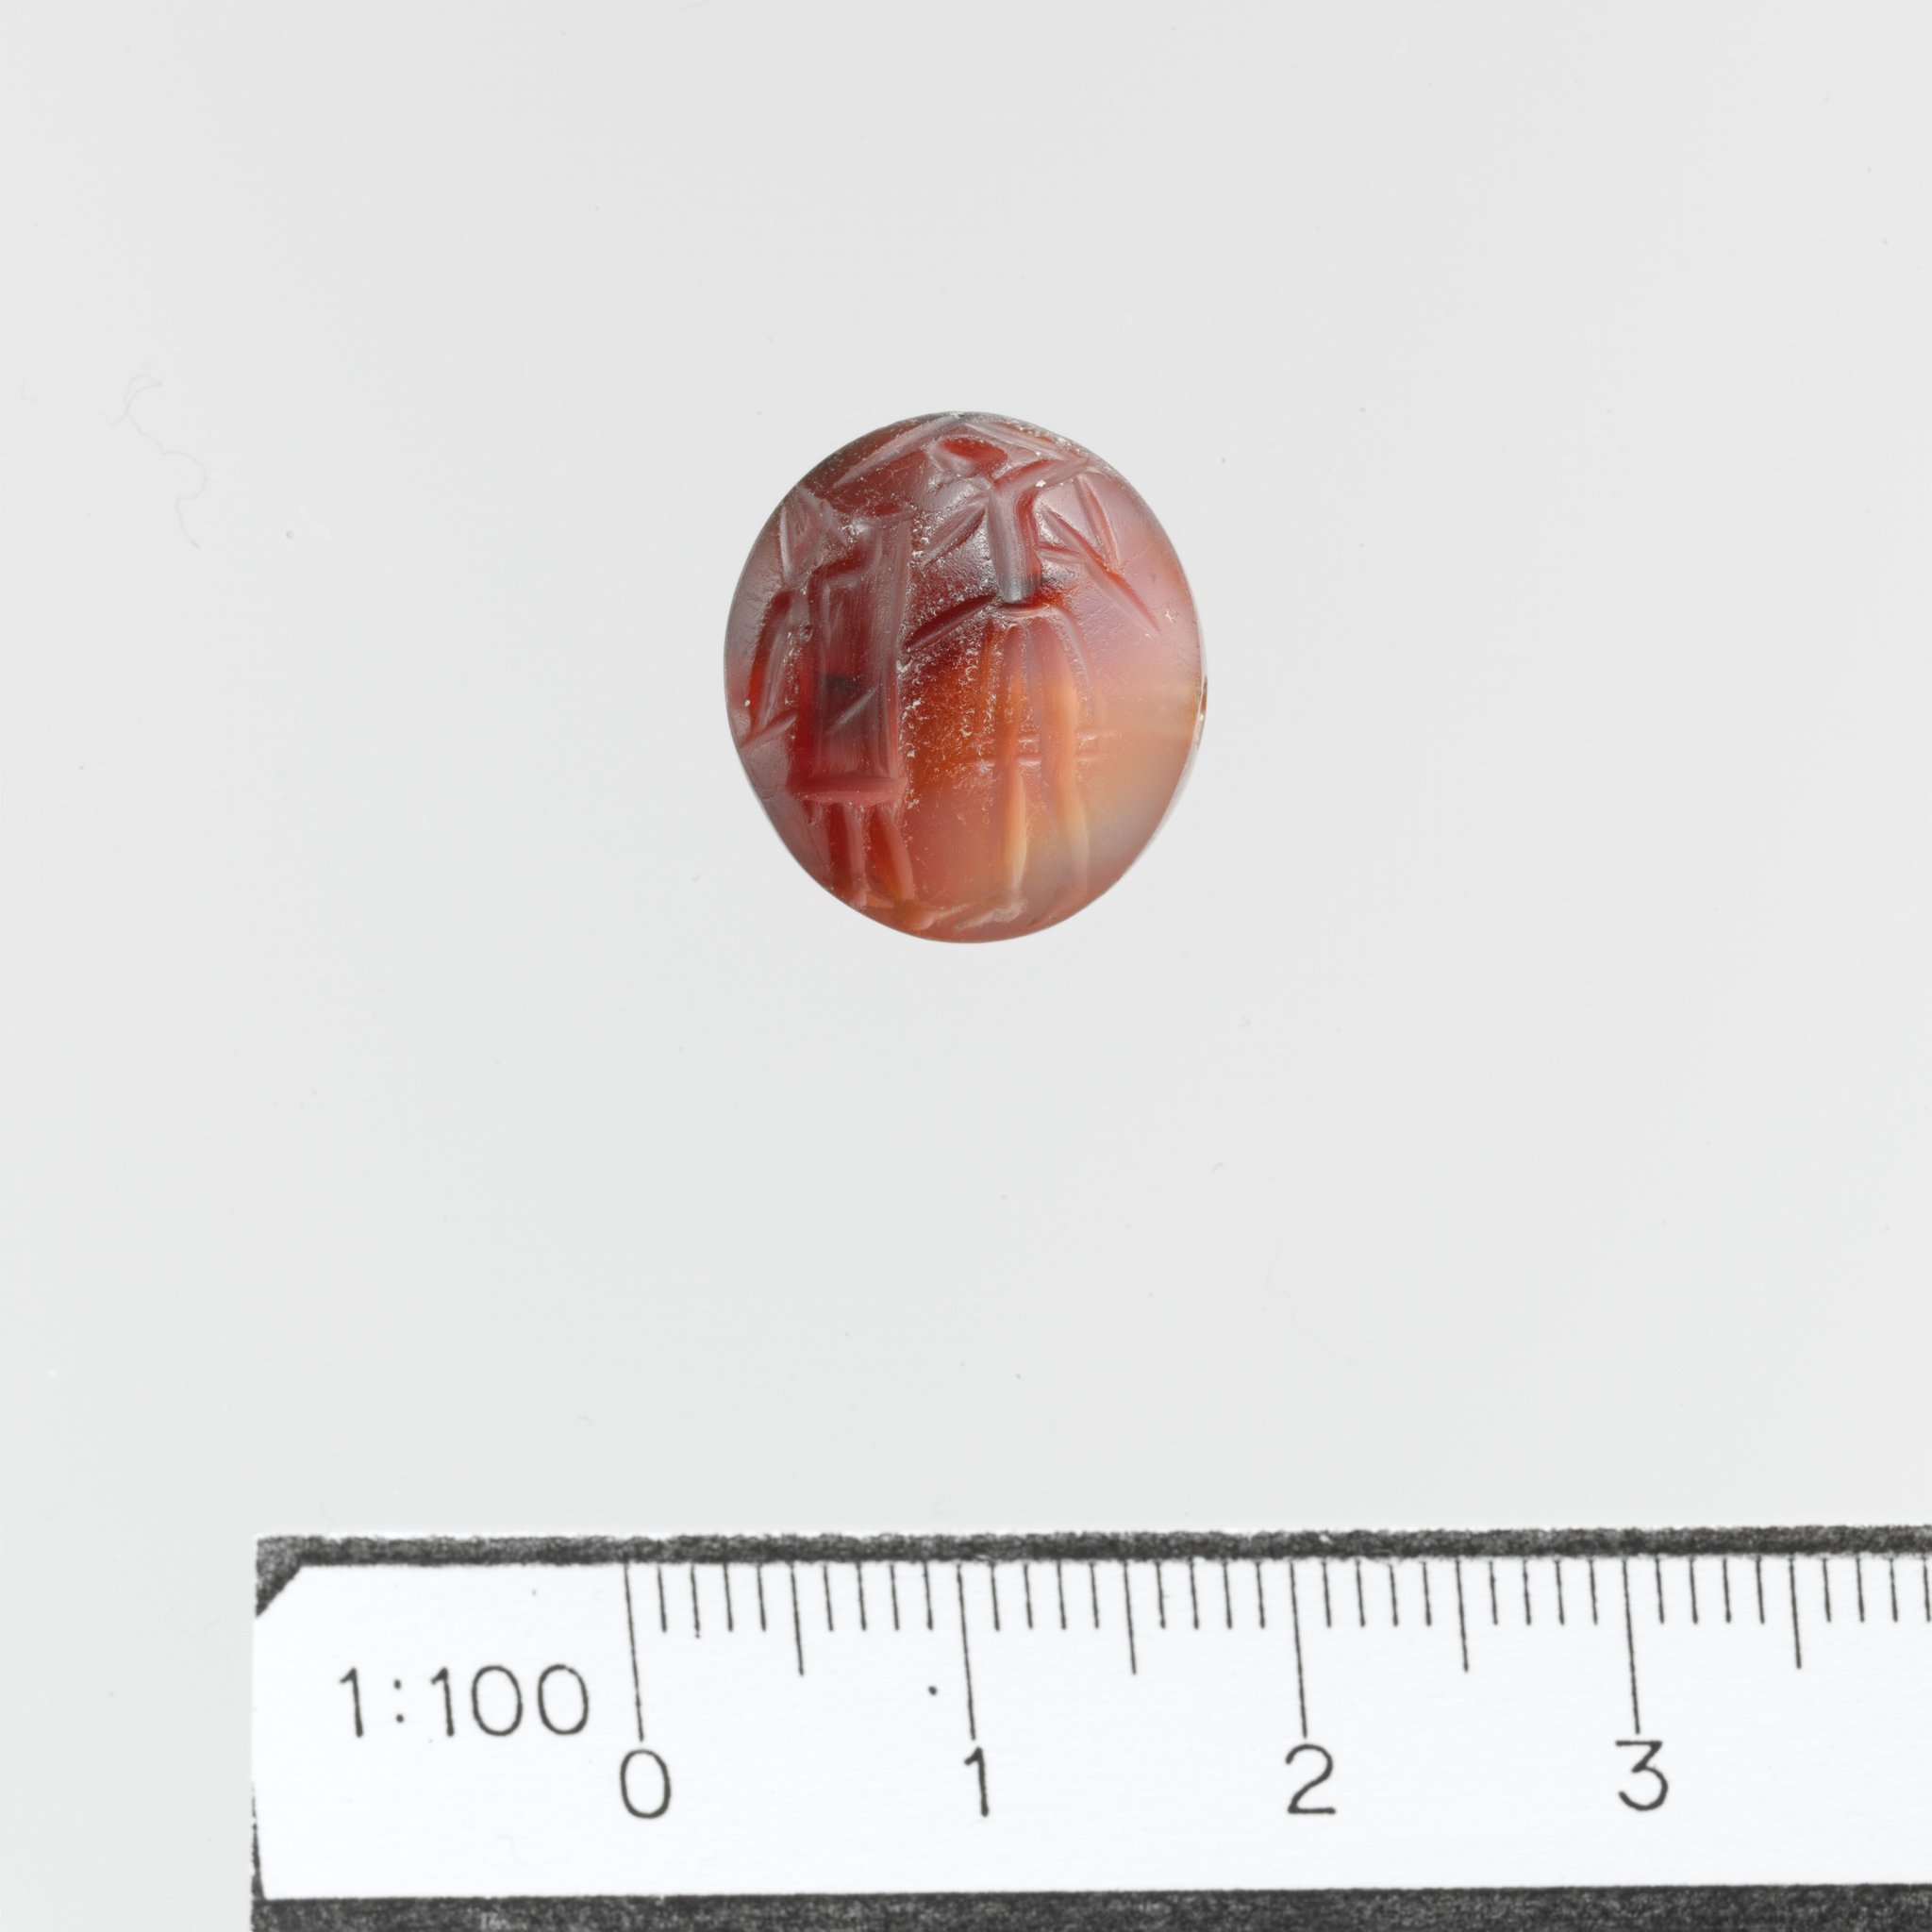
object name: seal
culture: minoan, crete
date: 2000-1450 BCE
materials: gemstone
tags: human figures